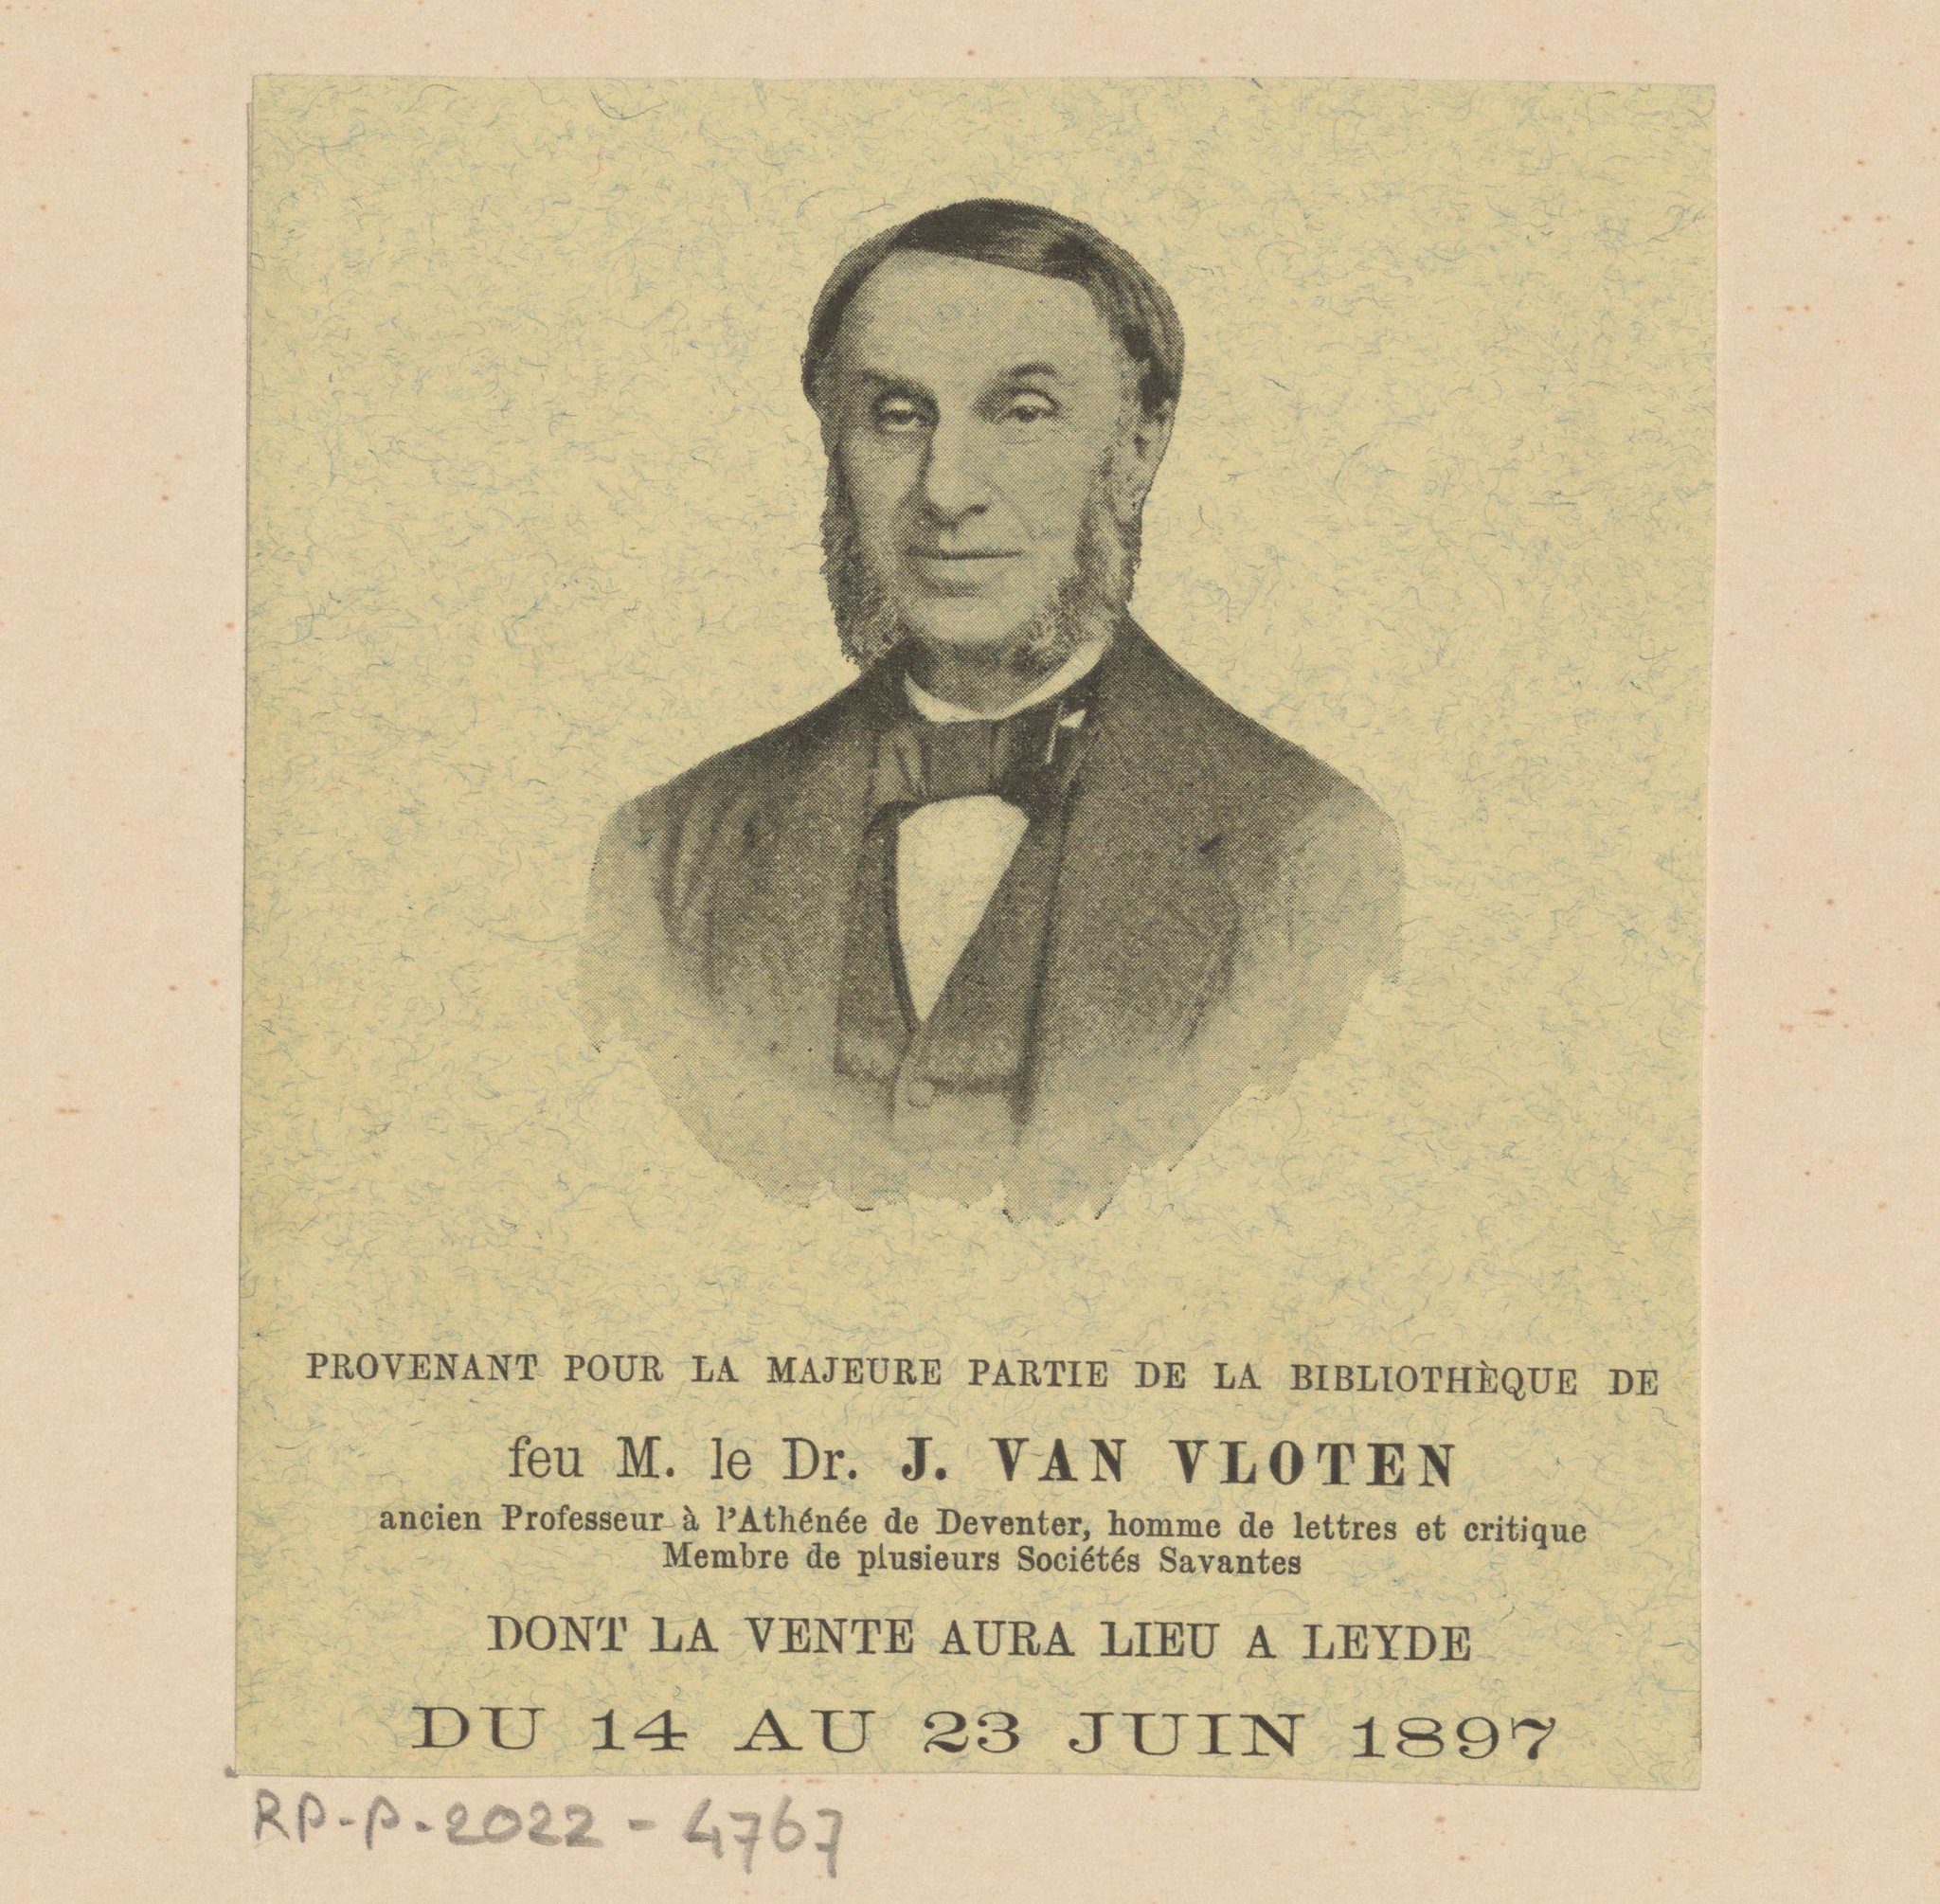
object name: photomechanical print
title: Portret van Johannes van Vloten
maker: Anonymous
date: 1897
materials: paper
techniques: letterpress printing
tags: haarlem, johannes van vloten, historical persons, portrait of a writer